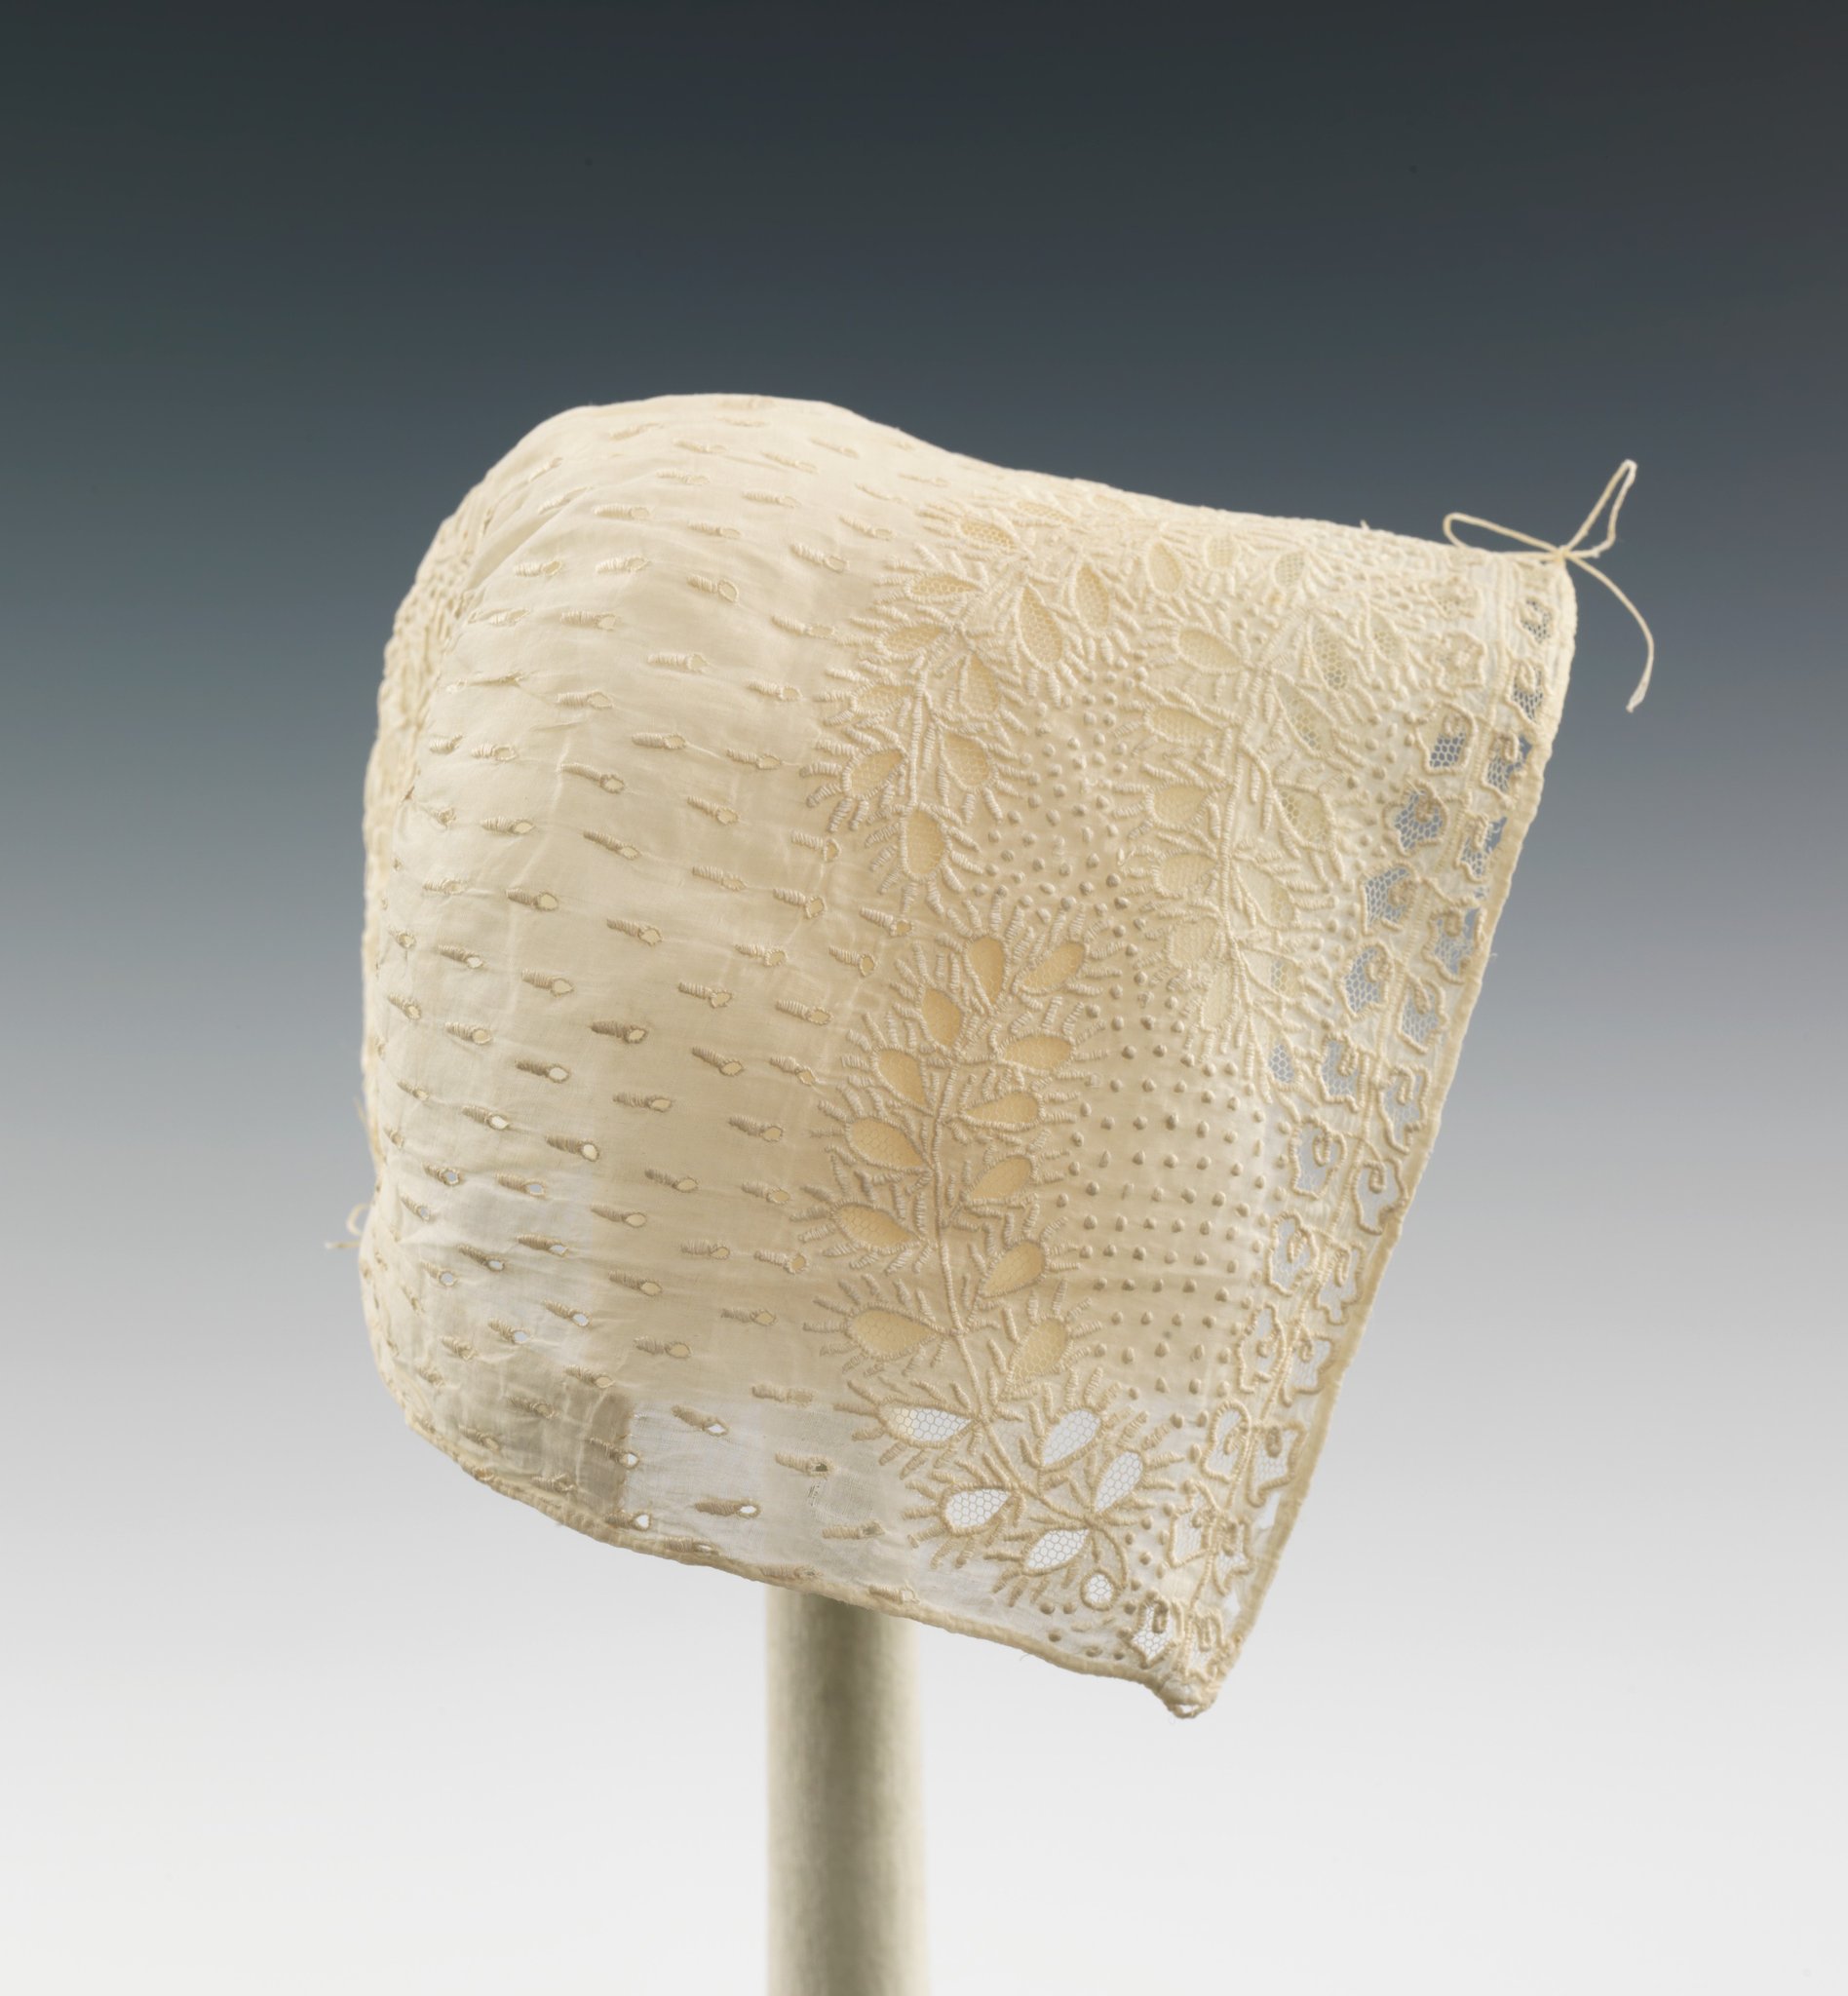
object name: cap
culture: american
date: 1830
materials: cotton